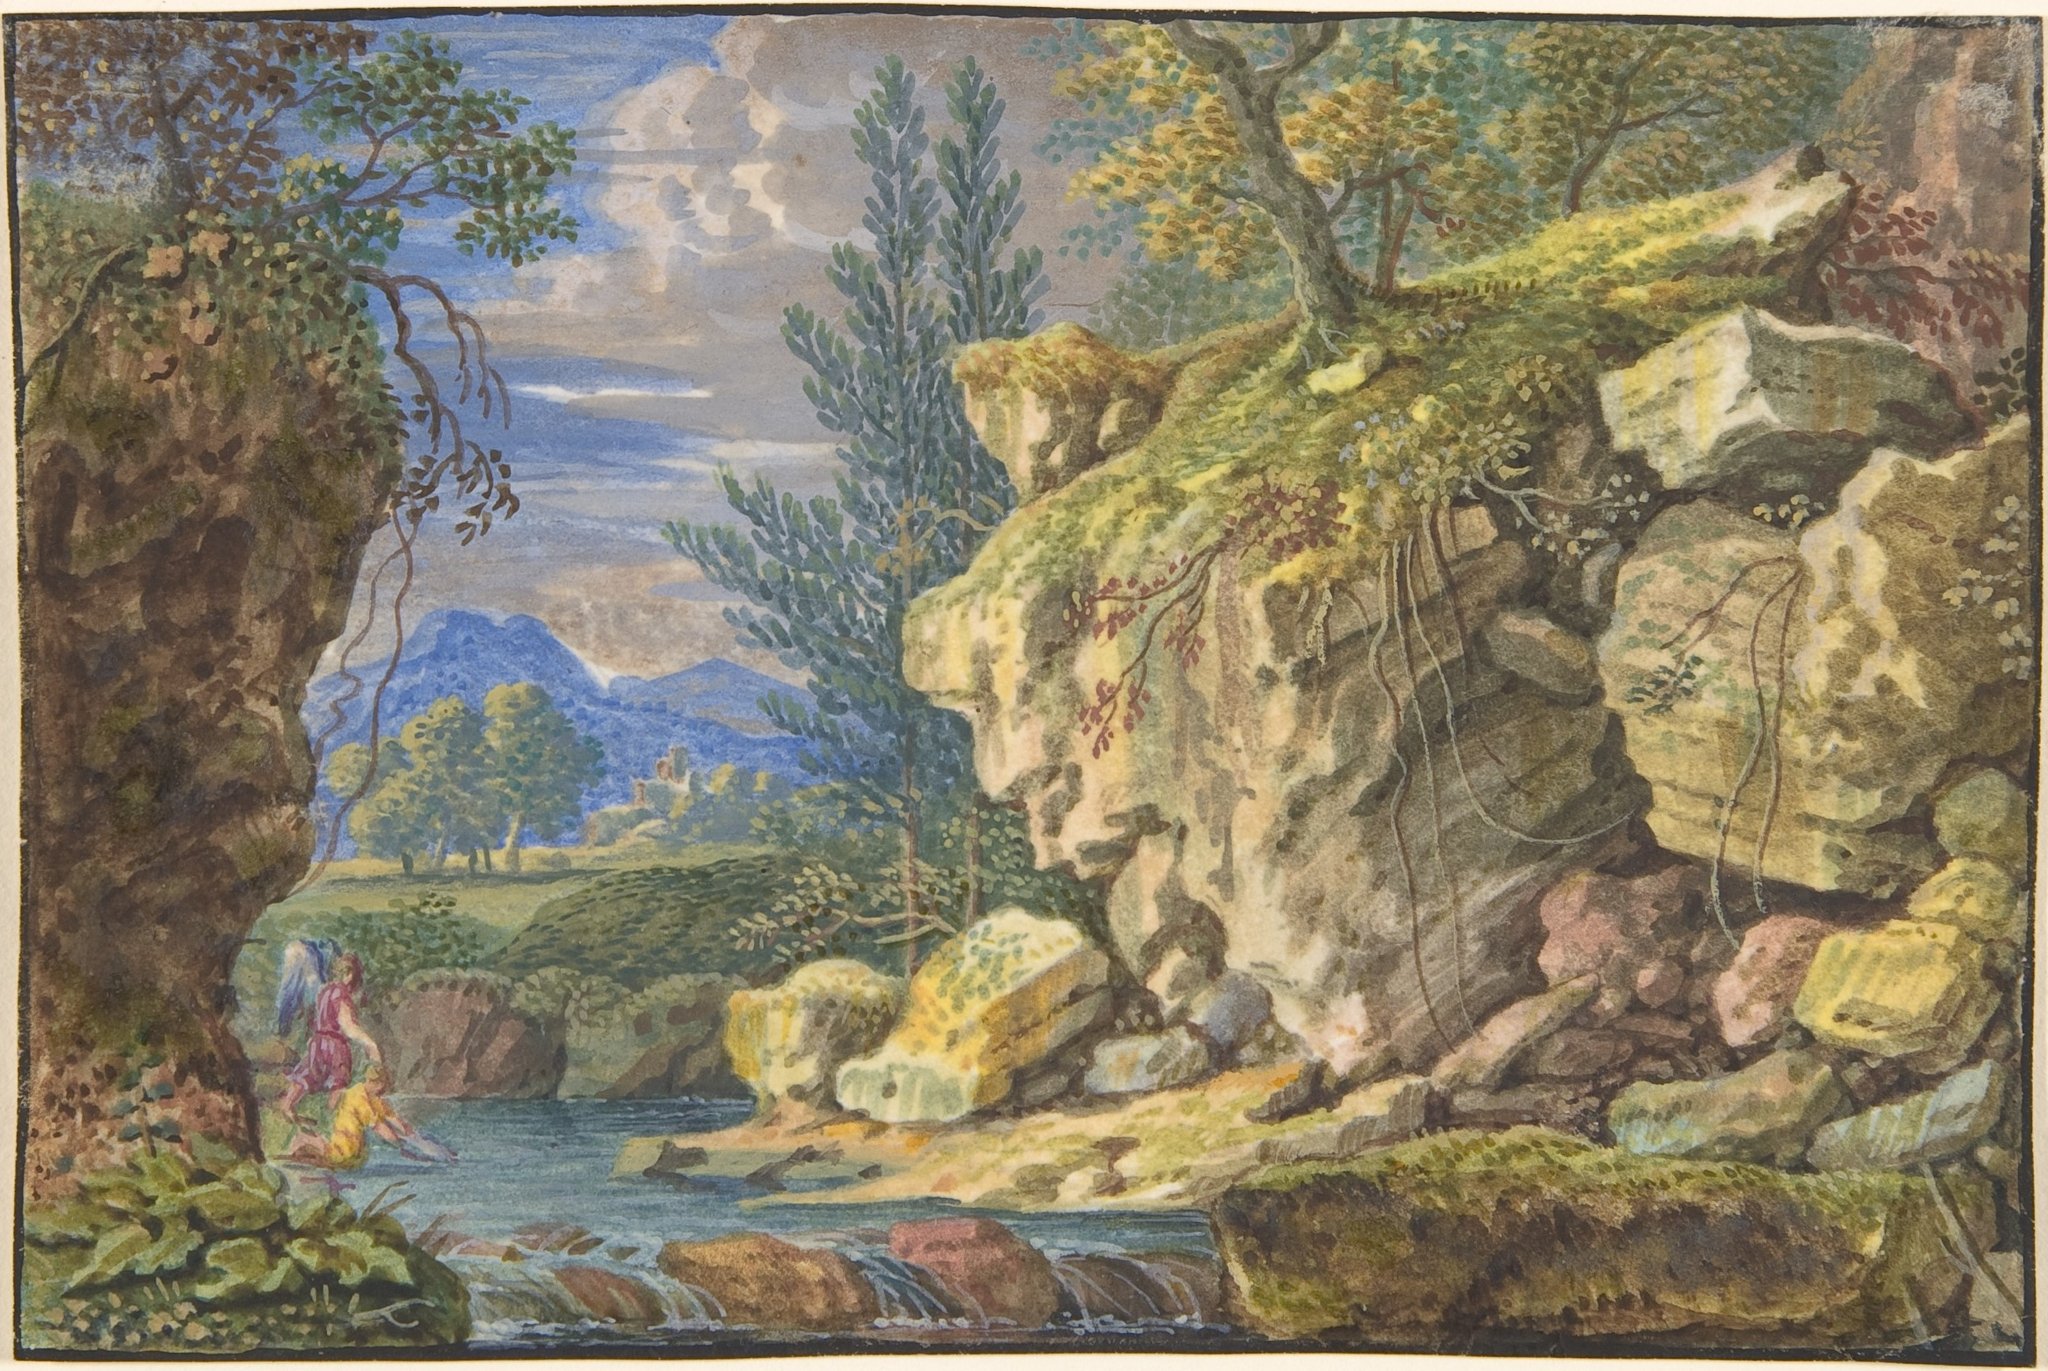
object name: drawing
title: Landscape with Tobias and the Angel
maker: felix meyer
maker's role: artist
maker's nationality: swiss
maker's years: 1653-1713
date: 1667-1733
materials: watercolor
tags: landscapes,angels,goddess